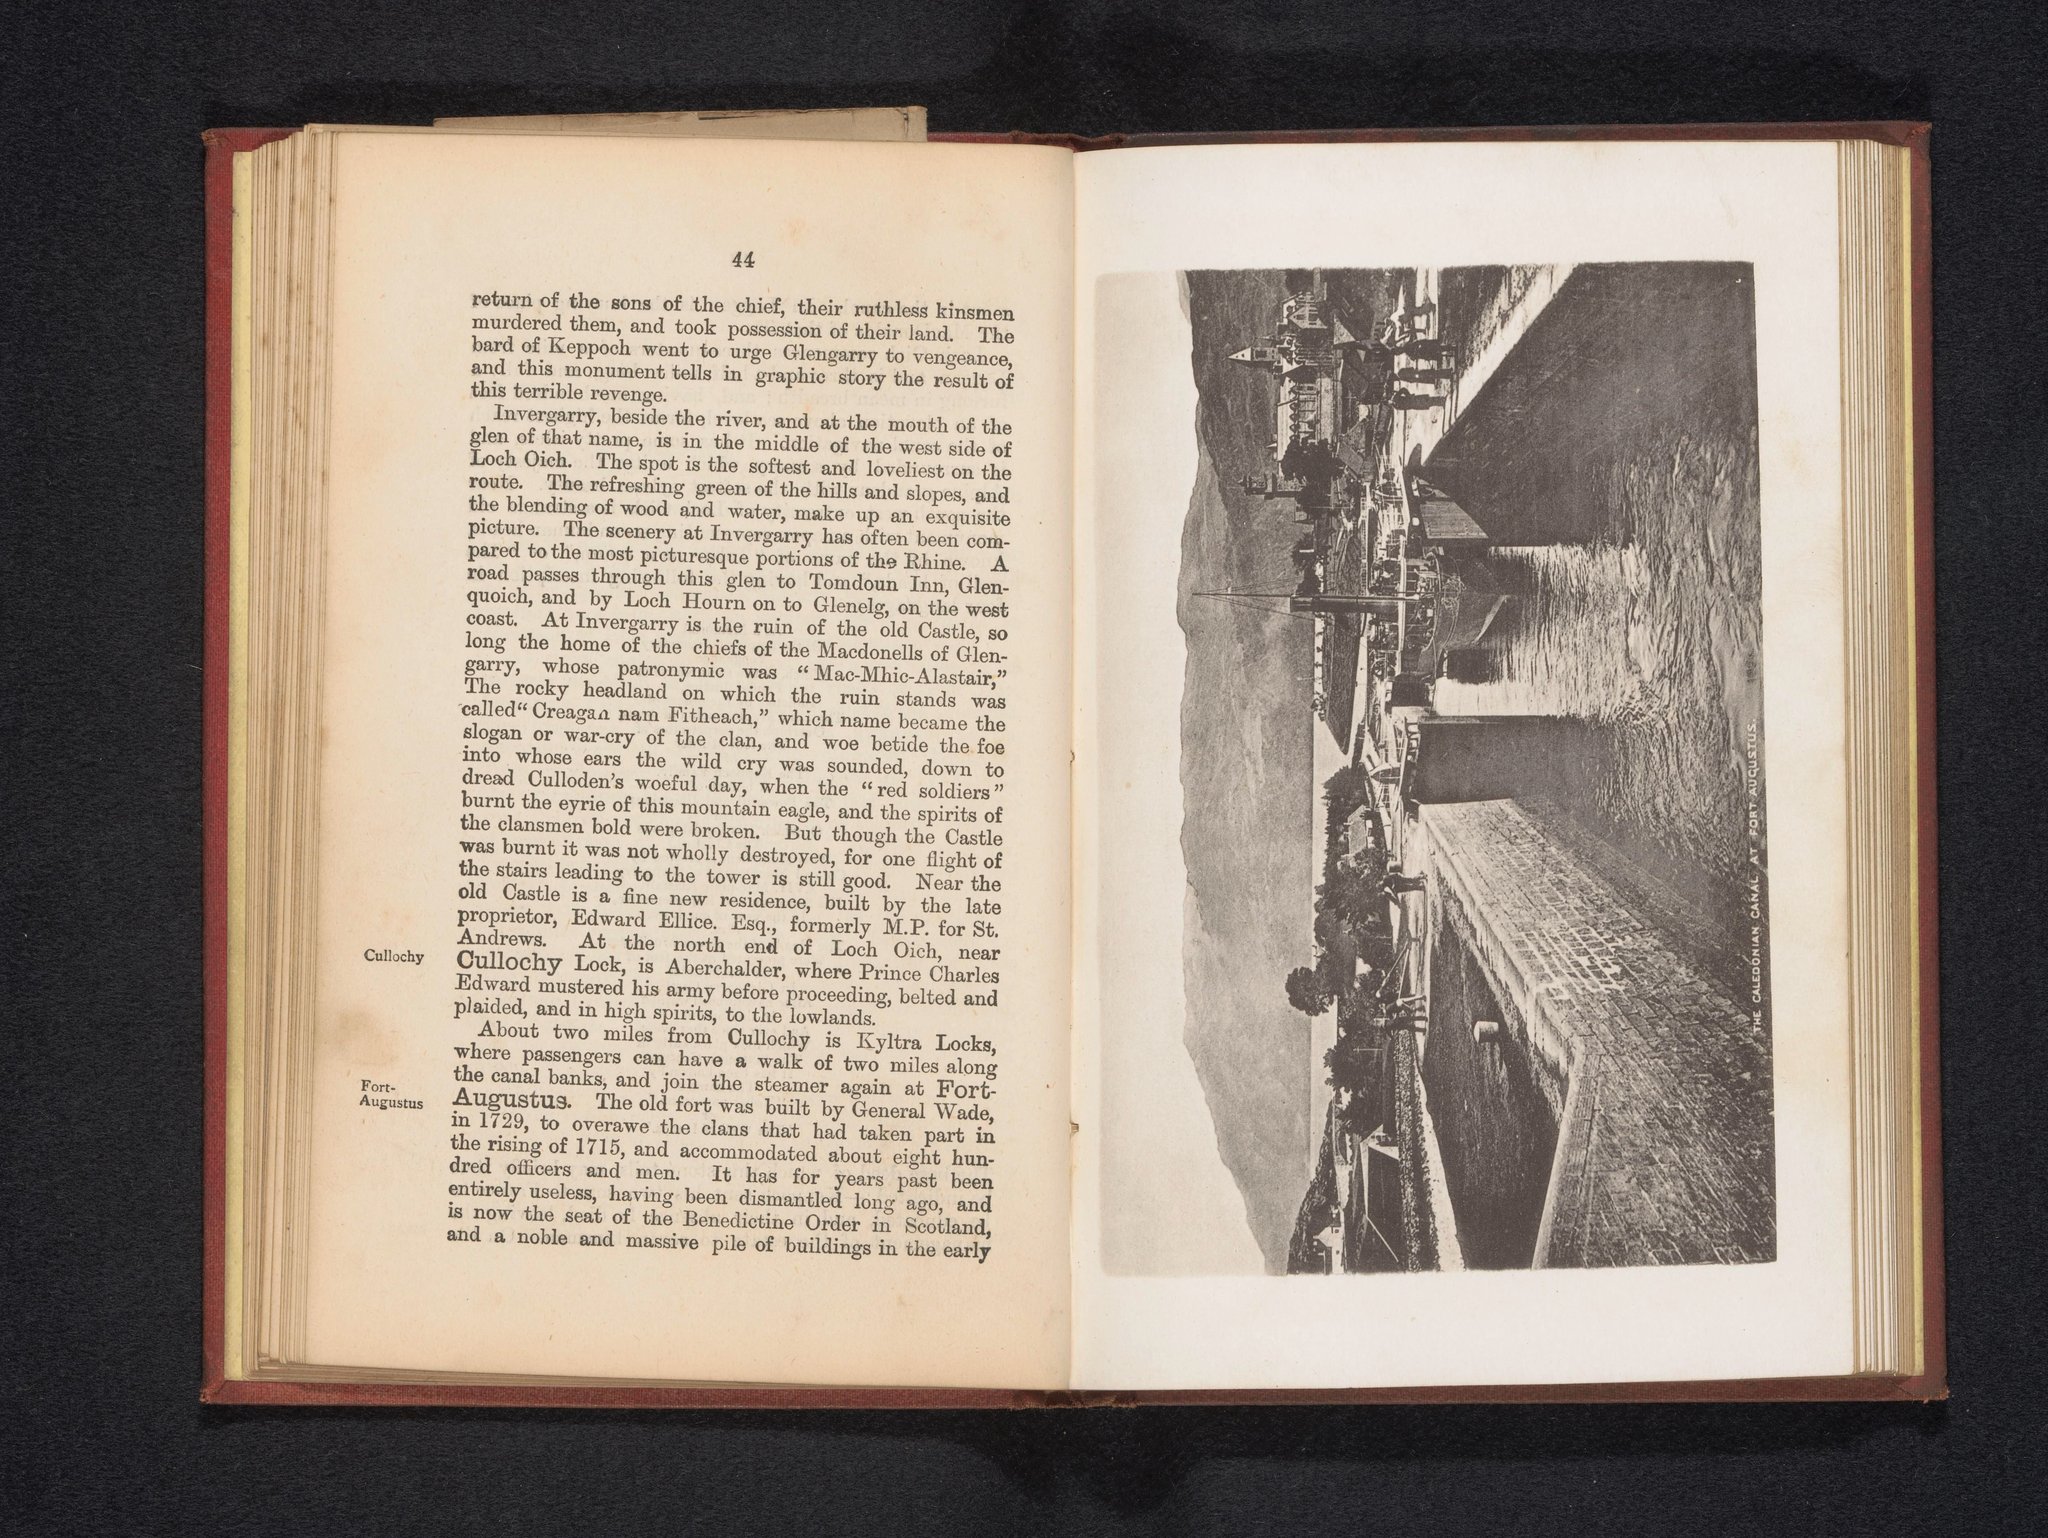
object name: photomechanical print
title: Gezicht op het Caledonish Kanaal bij Fort Augustus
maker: Anonymous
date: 1881-1886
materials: paper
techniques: photograph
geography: fort augustus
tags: sluice, weir, city-view in general; 'veduta', canals, waters (in city)